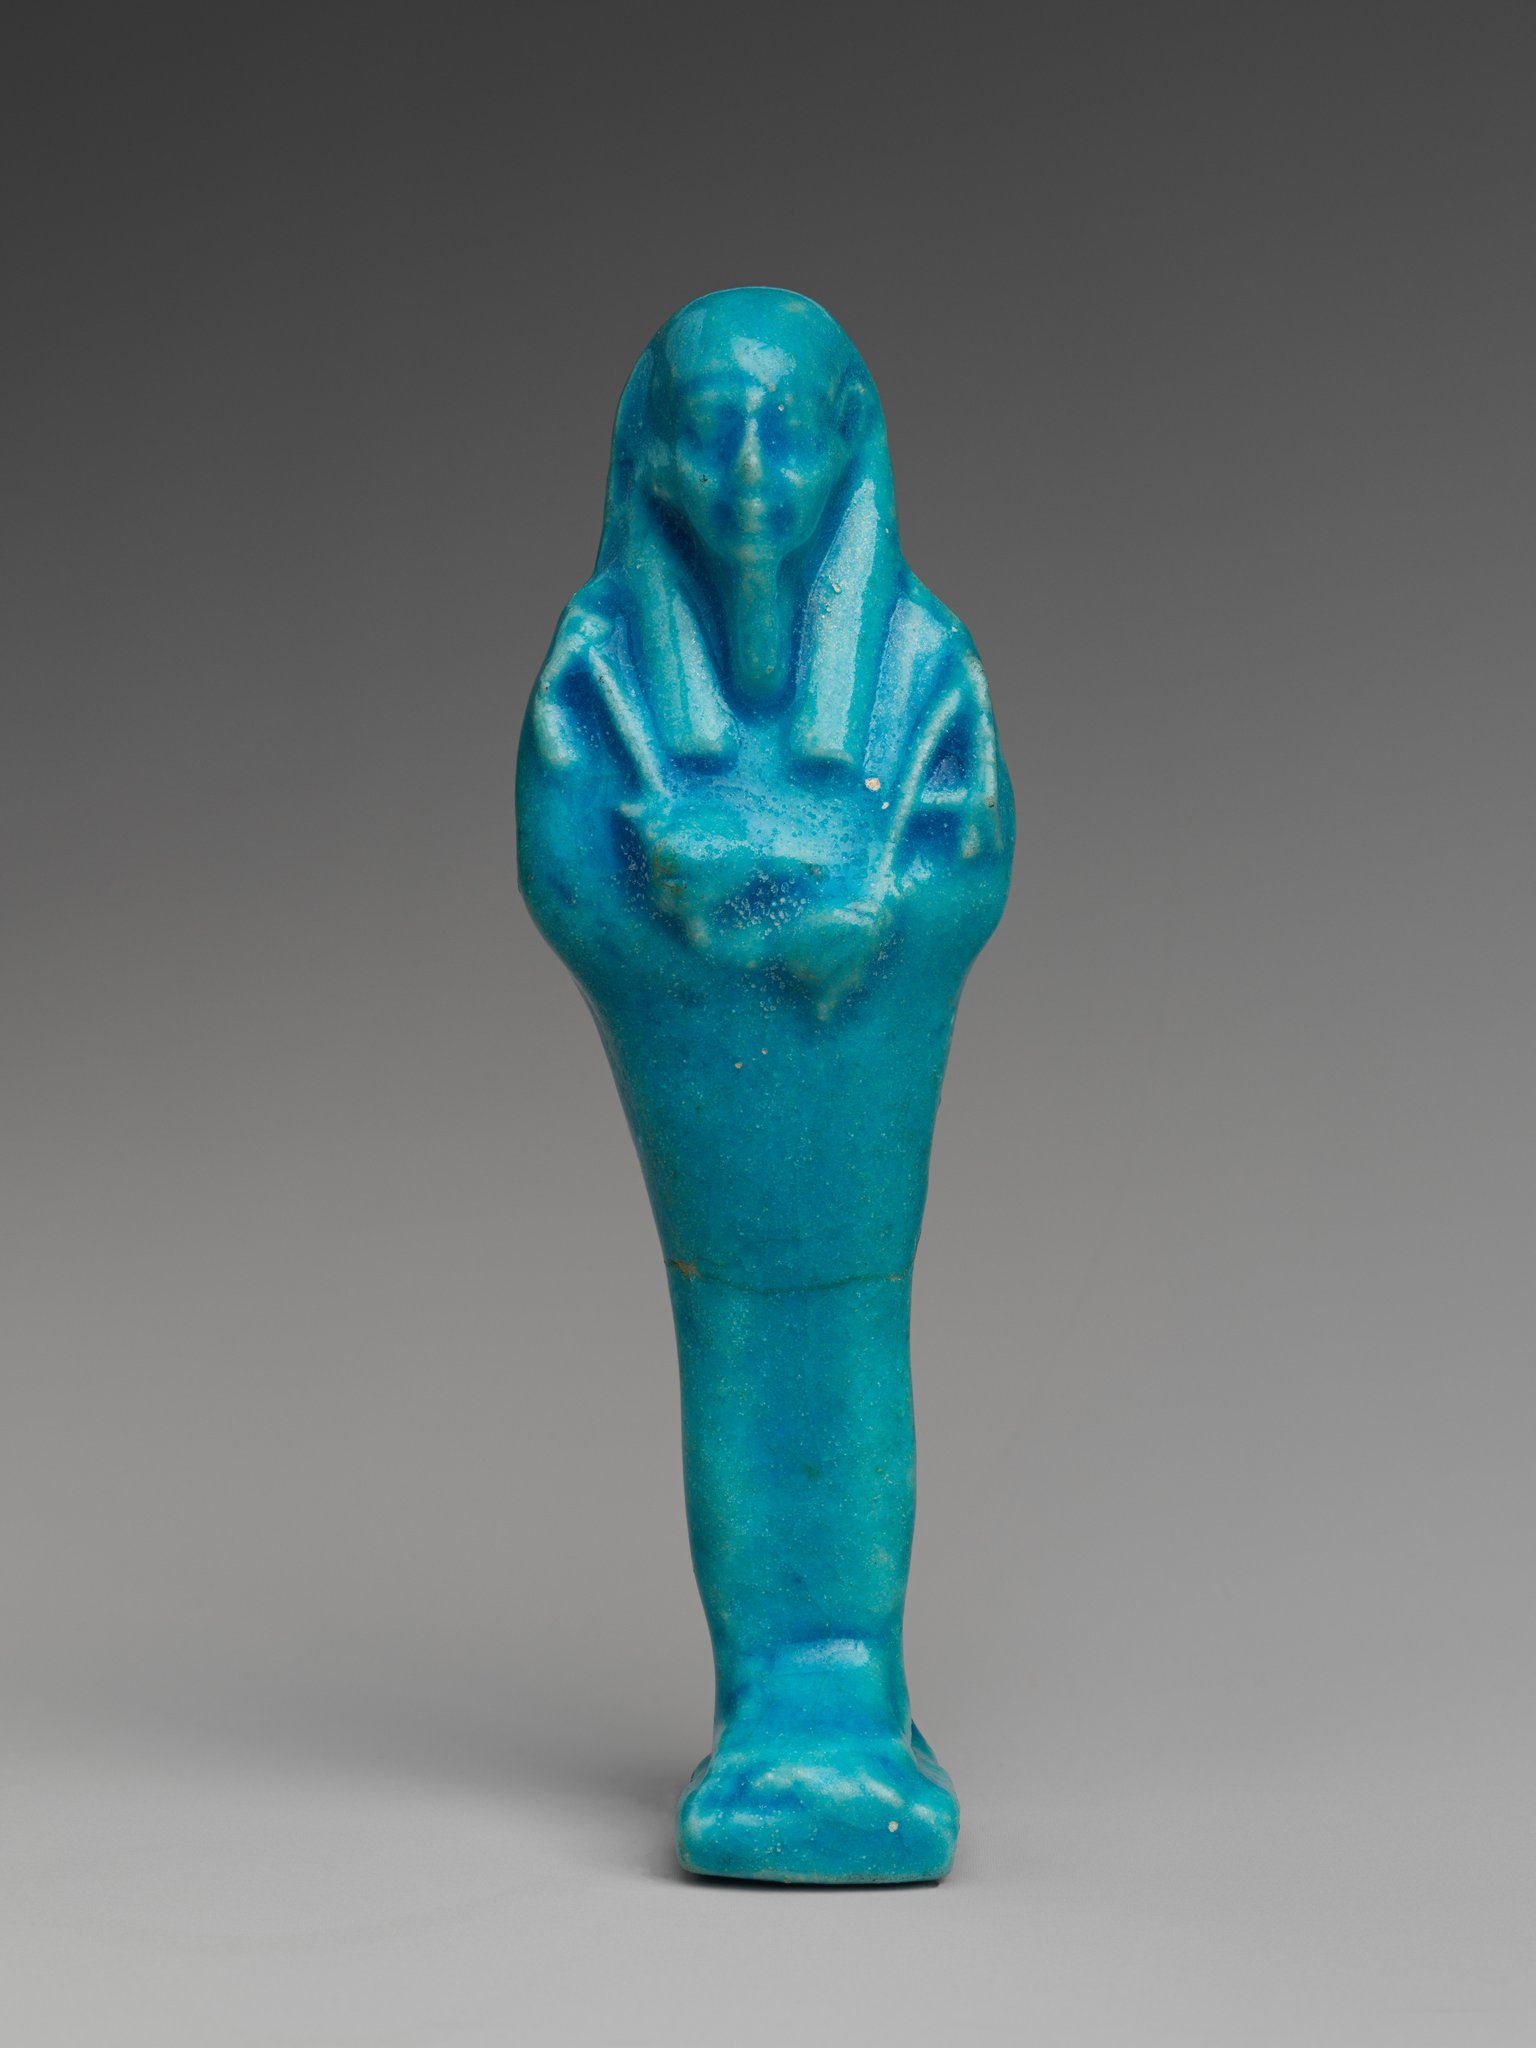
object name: shabti, petosiris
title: Shabti of Petosiris, son of Djedhor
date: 360-300 BCE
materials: faience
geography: egypt